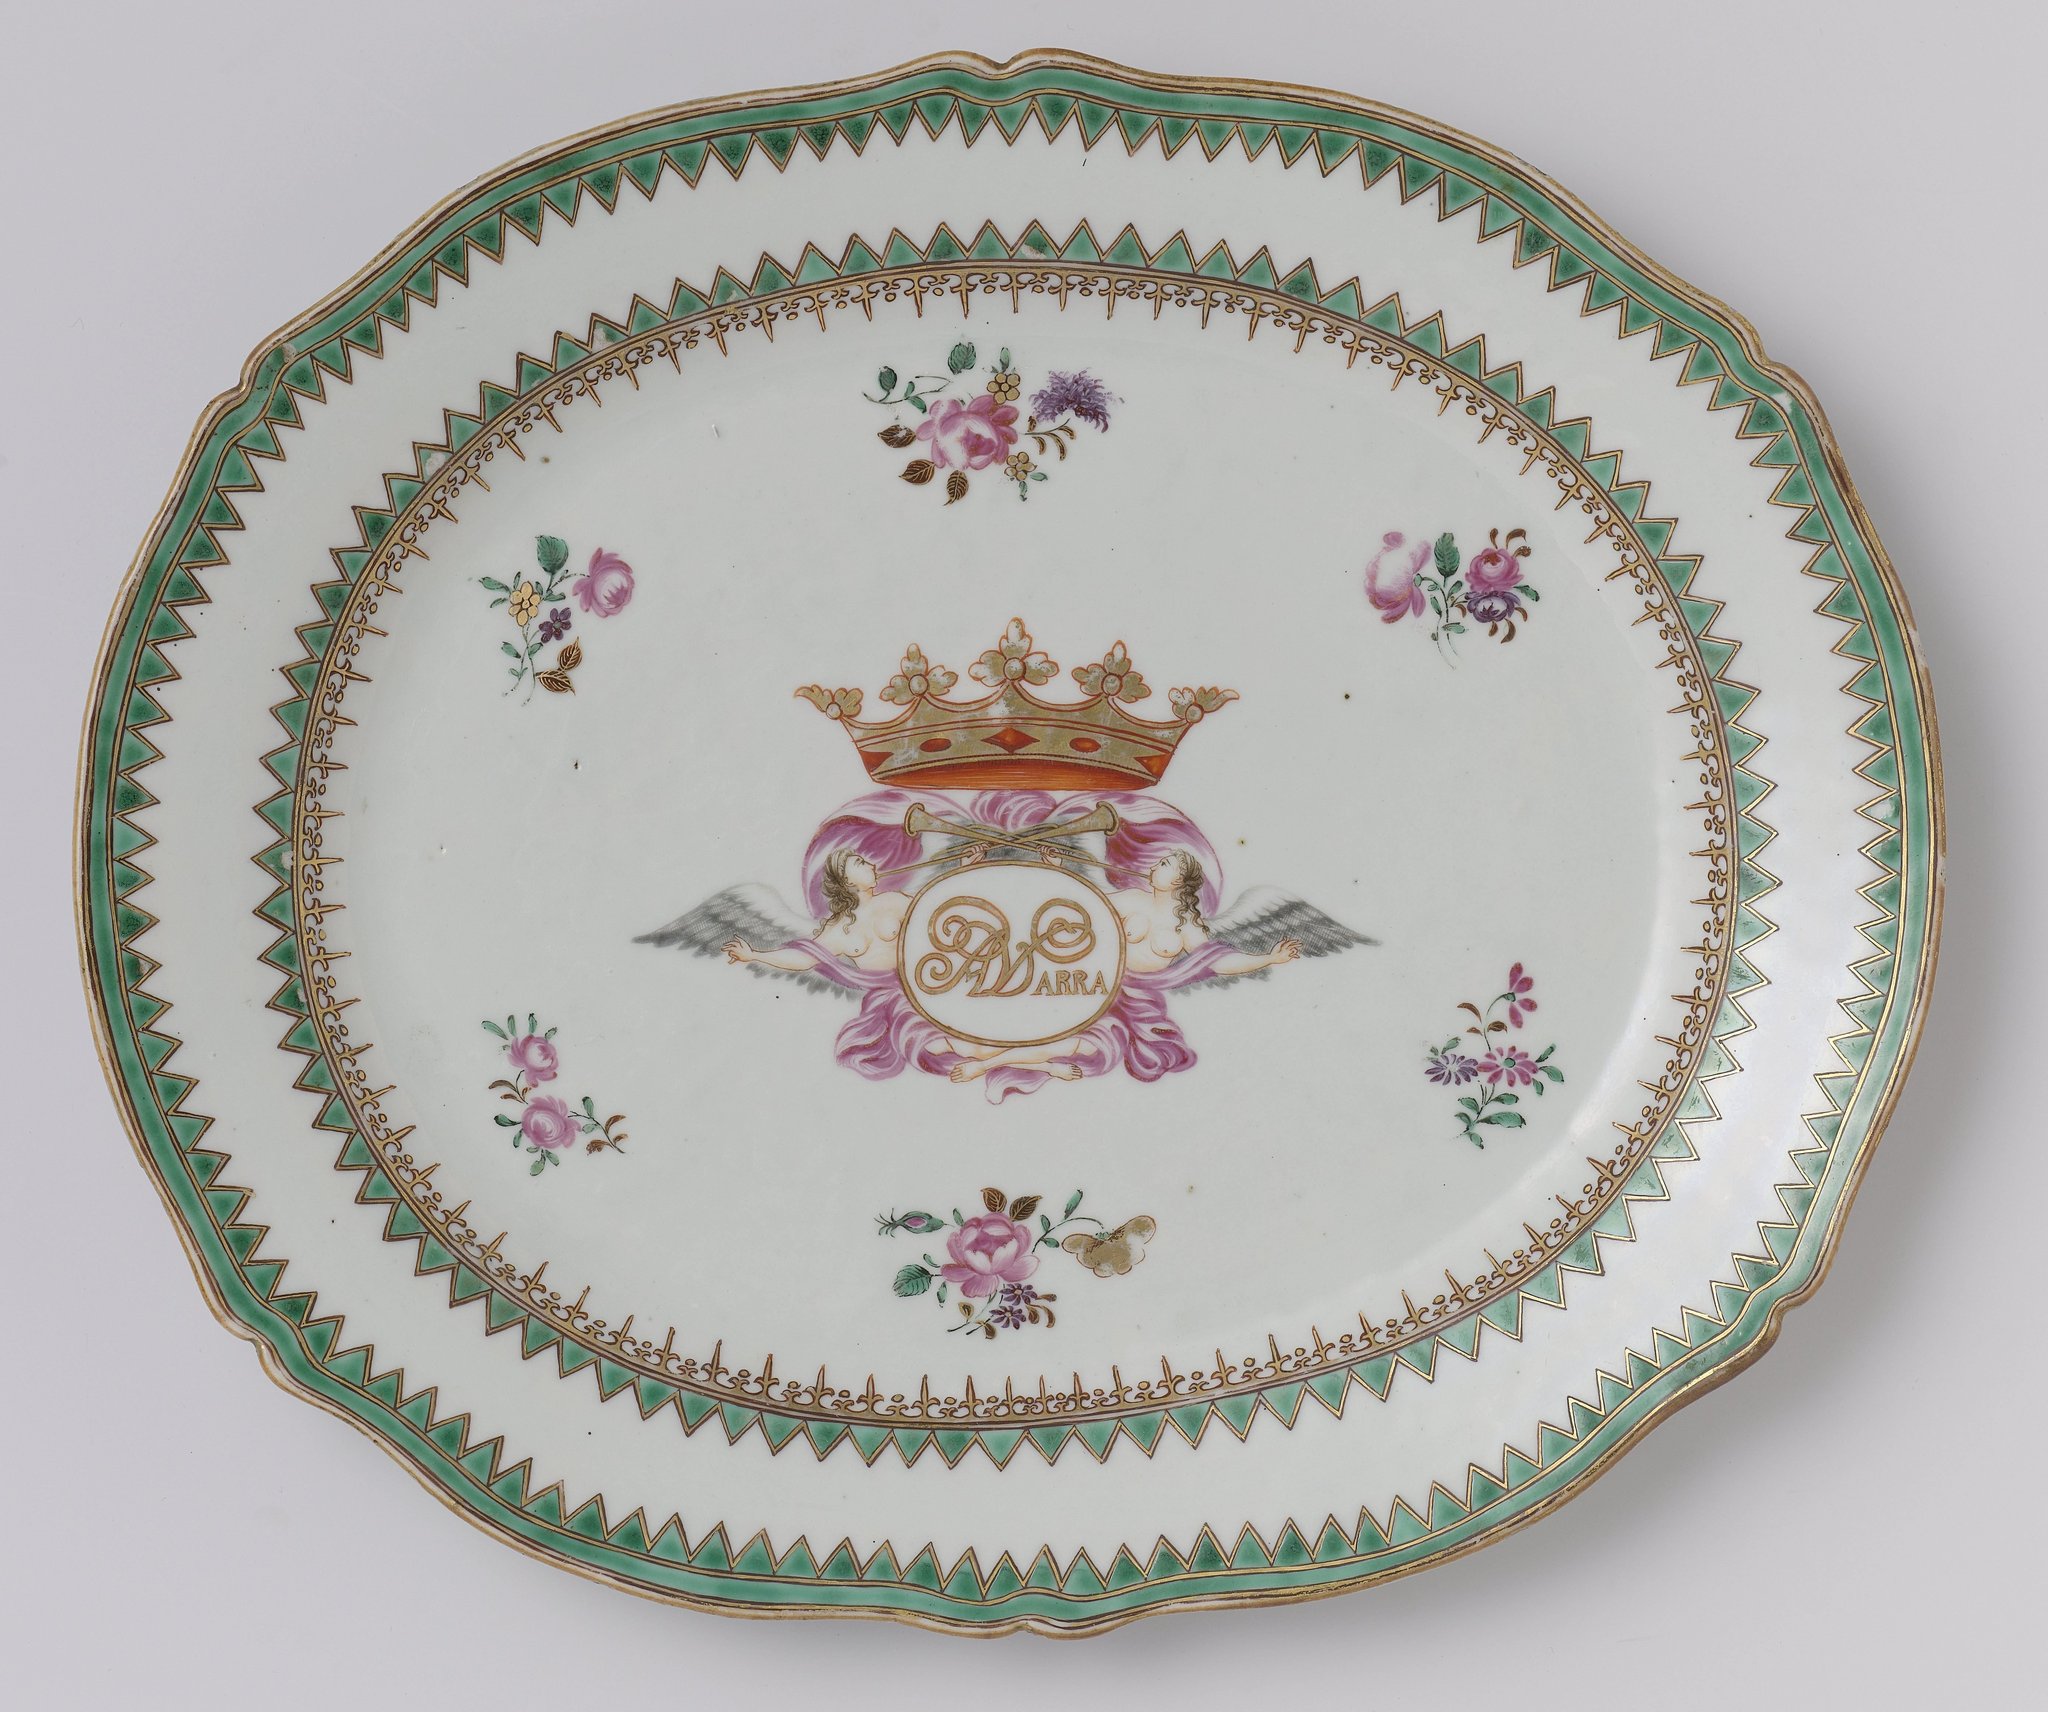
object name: platter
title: Oval dish with the arms of the Van der Parra family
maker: Anonymous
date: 1750-1774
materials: glaze, gold, paint, porcelain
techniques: firing, gilding, turning, vitrification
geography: china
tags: dutch east indies, the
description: Ovale schotel van porselein met geschulpte rand, beschilderd op het glazuur in rood, roze, groen, paars, zwart en goud. In het centrum het wapen van Petrus Albertus van de Parra (1714-1775). In het schild staat de naam ‘PA VD PARRA’ in goud en ijzerrood. Boven het wapen is een kroon afgebeeld en het dekkleed bestaat uit een draperie in paars en aan weerszijden van het wapen een engel die de bazuin blaast. Hieromheen zijn bloemtakken afgebeeld. Op de wand een band van spearheads in goud. De rand wordt begrensd met een dubbel zaagtand-motief. Wapenporselein.